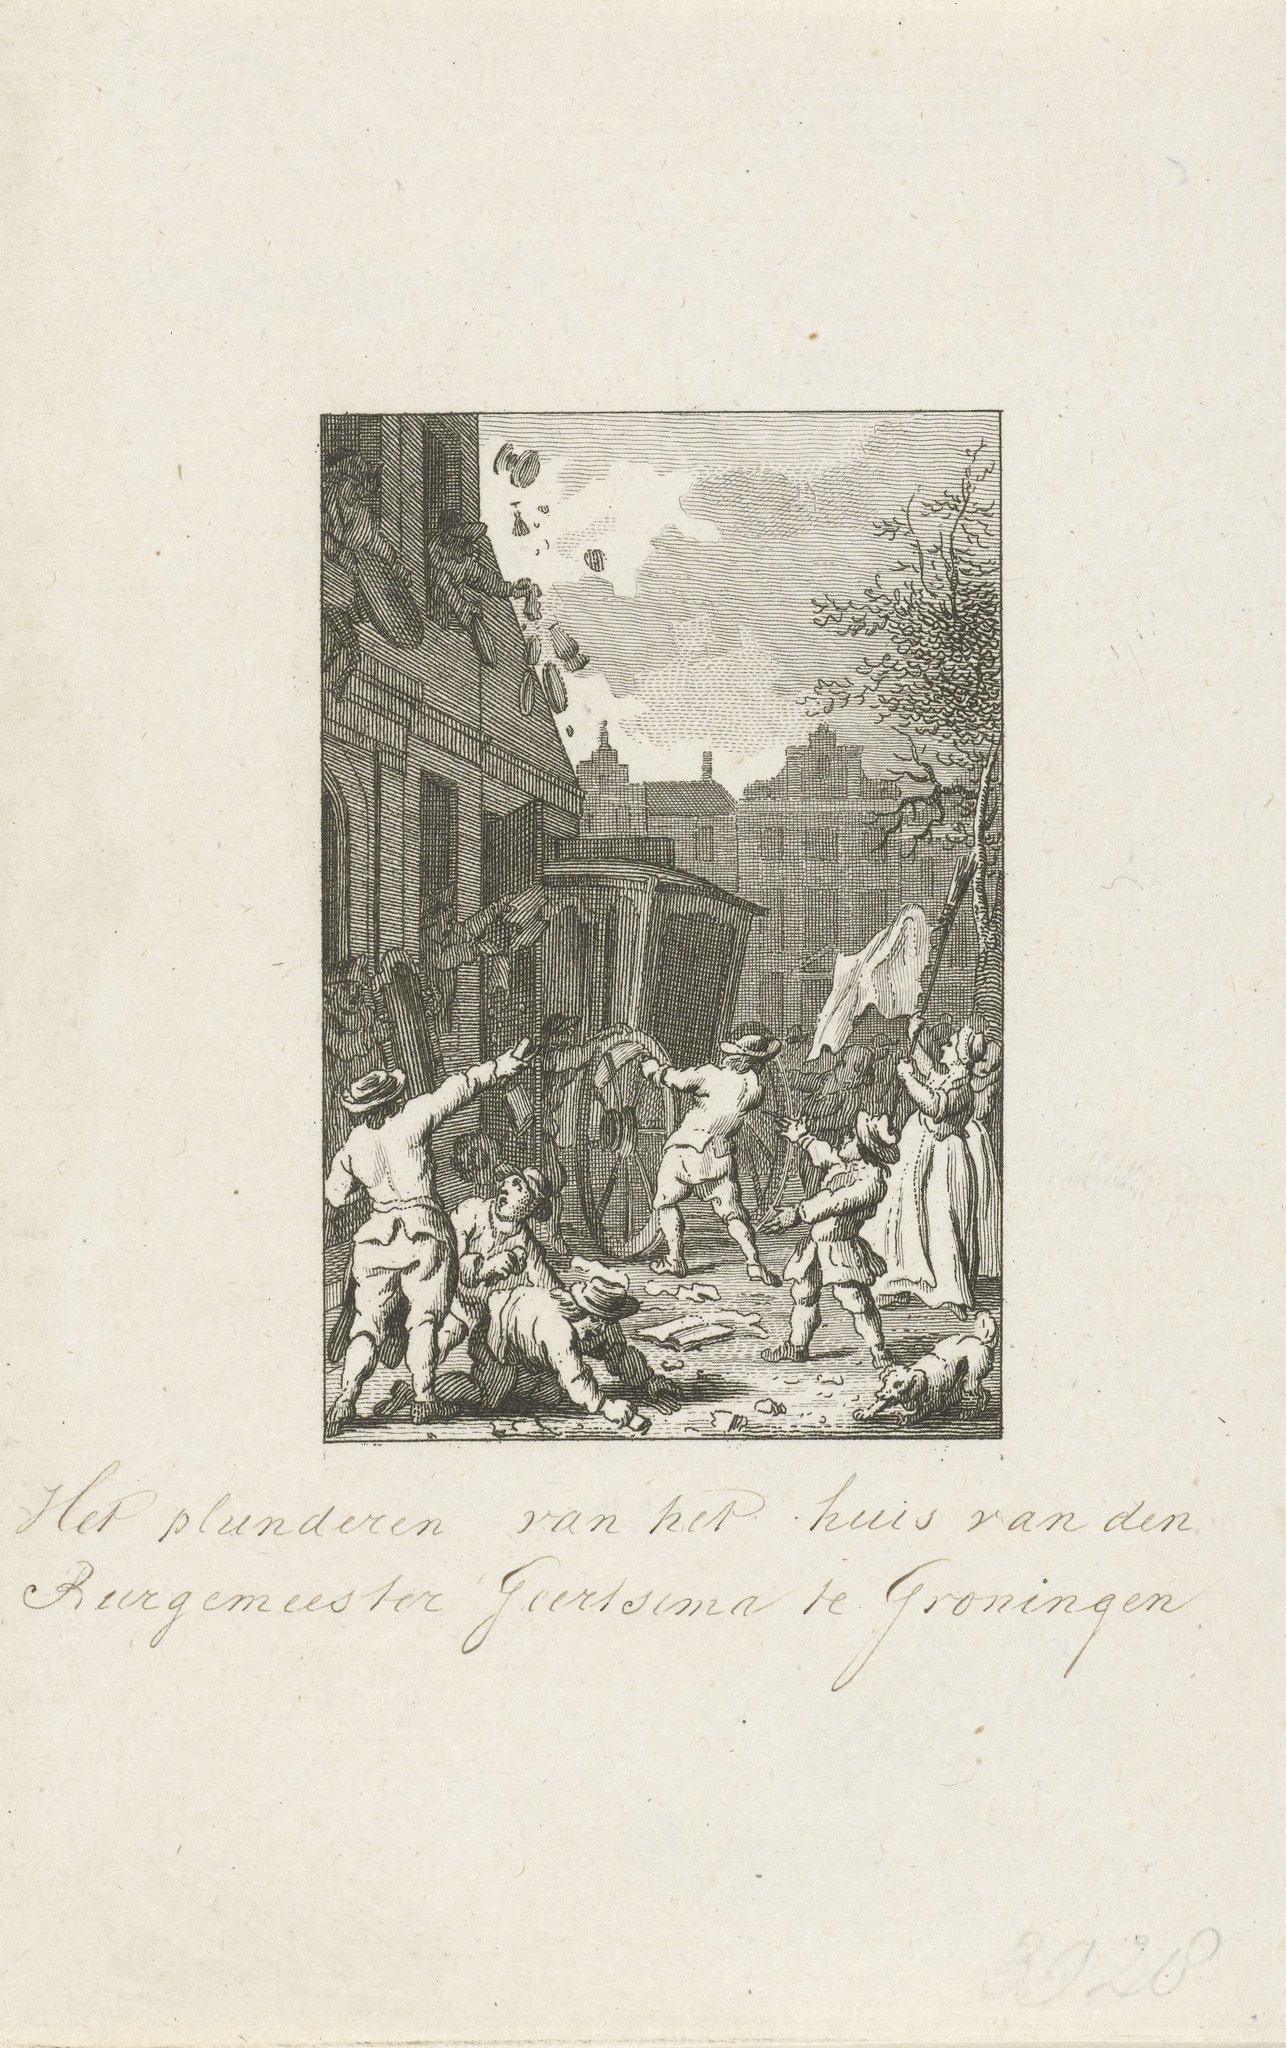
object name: history print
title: Plundering van het huis van burgemeester Geertsema te Groningen, 1748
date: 1780-1795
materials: paper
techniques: etching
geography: northern netherlands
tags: mayor, plundering ~ riot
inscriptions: collector's mark: Lugt 2228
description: De plundering van het huis van burgemeester Geertsema te Groningen, 17 maart 1748. Een rijtuig wordt het water ingeduwd en spullen uit het huis gegooid door de oproerige menigte.